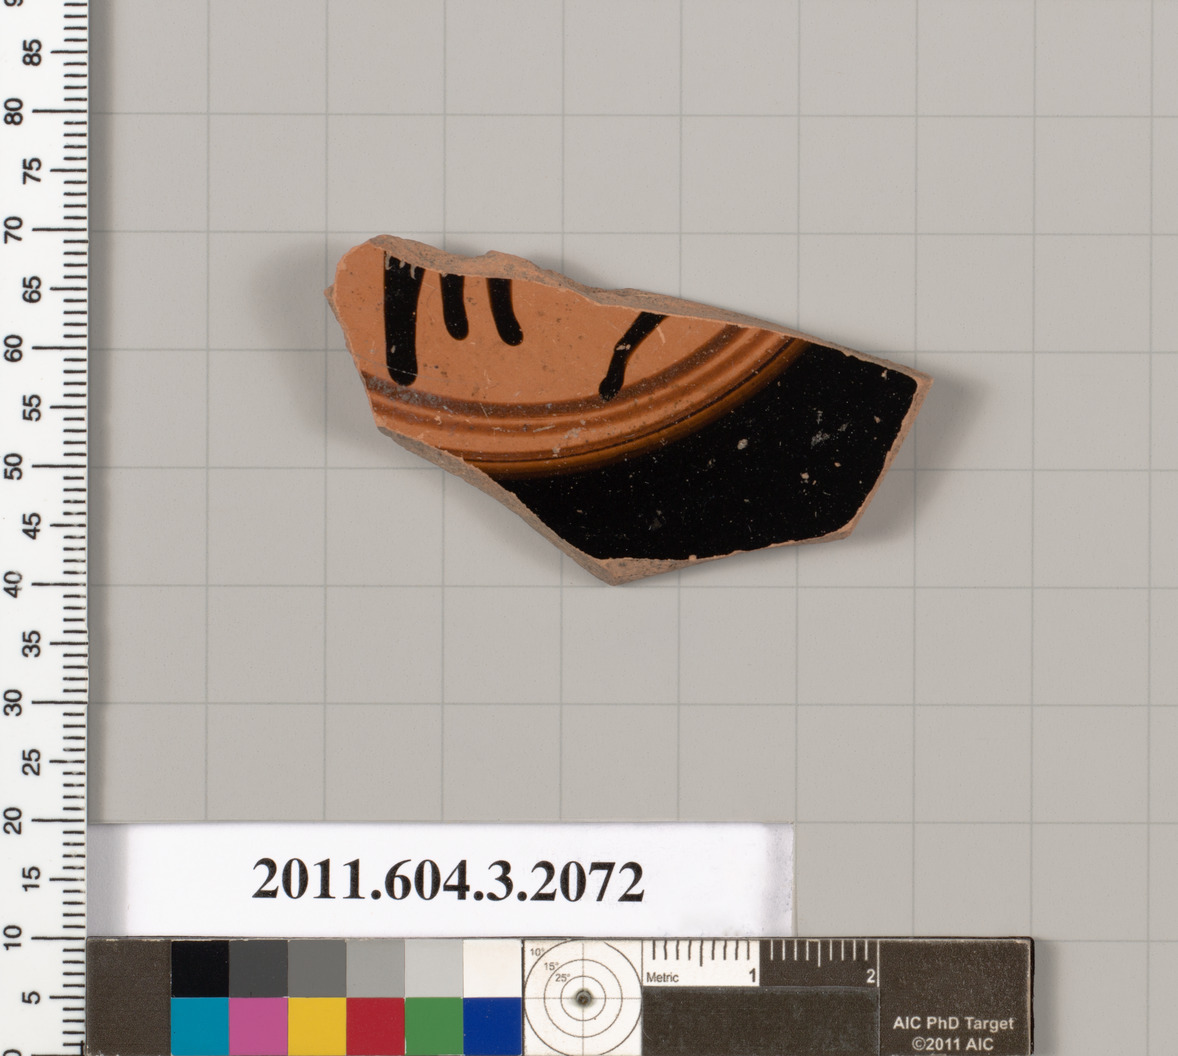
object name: kylix fragment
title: Terracotta fragment of a kylix (drinking cup)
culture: greek, attic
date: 500-468 BCE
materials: terracotta